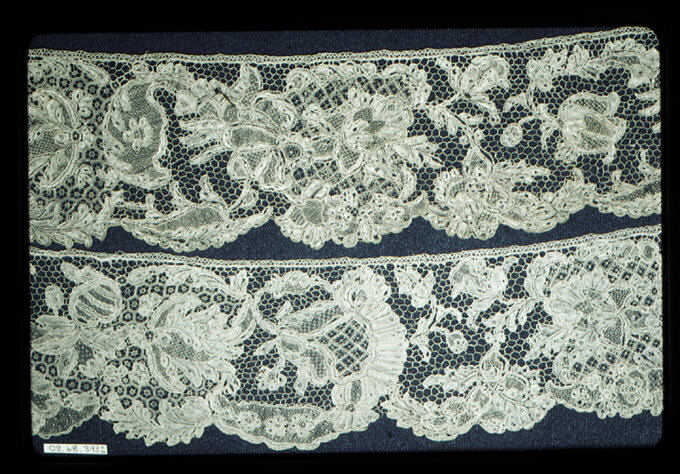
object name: sleeve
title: Sleeve (one of a pair)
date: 1701-1733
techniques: lace